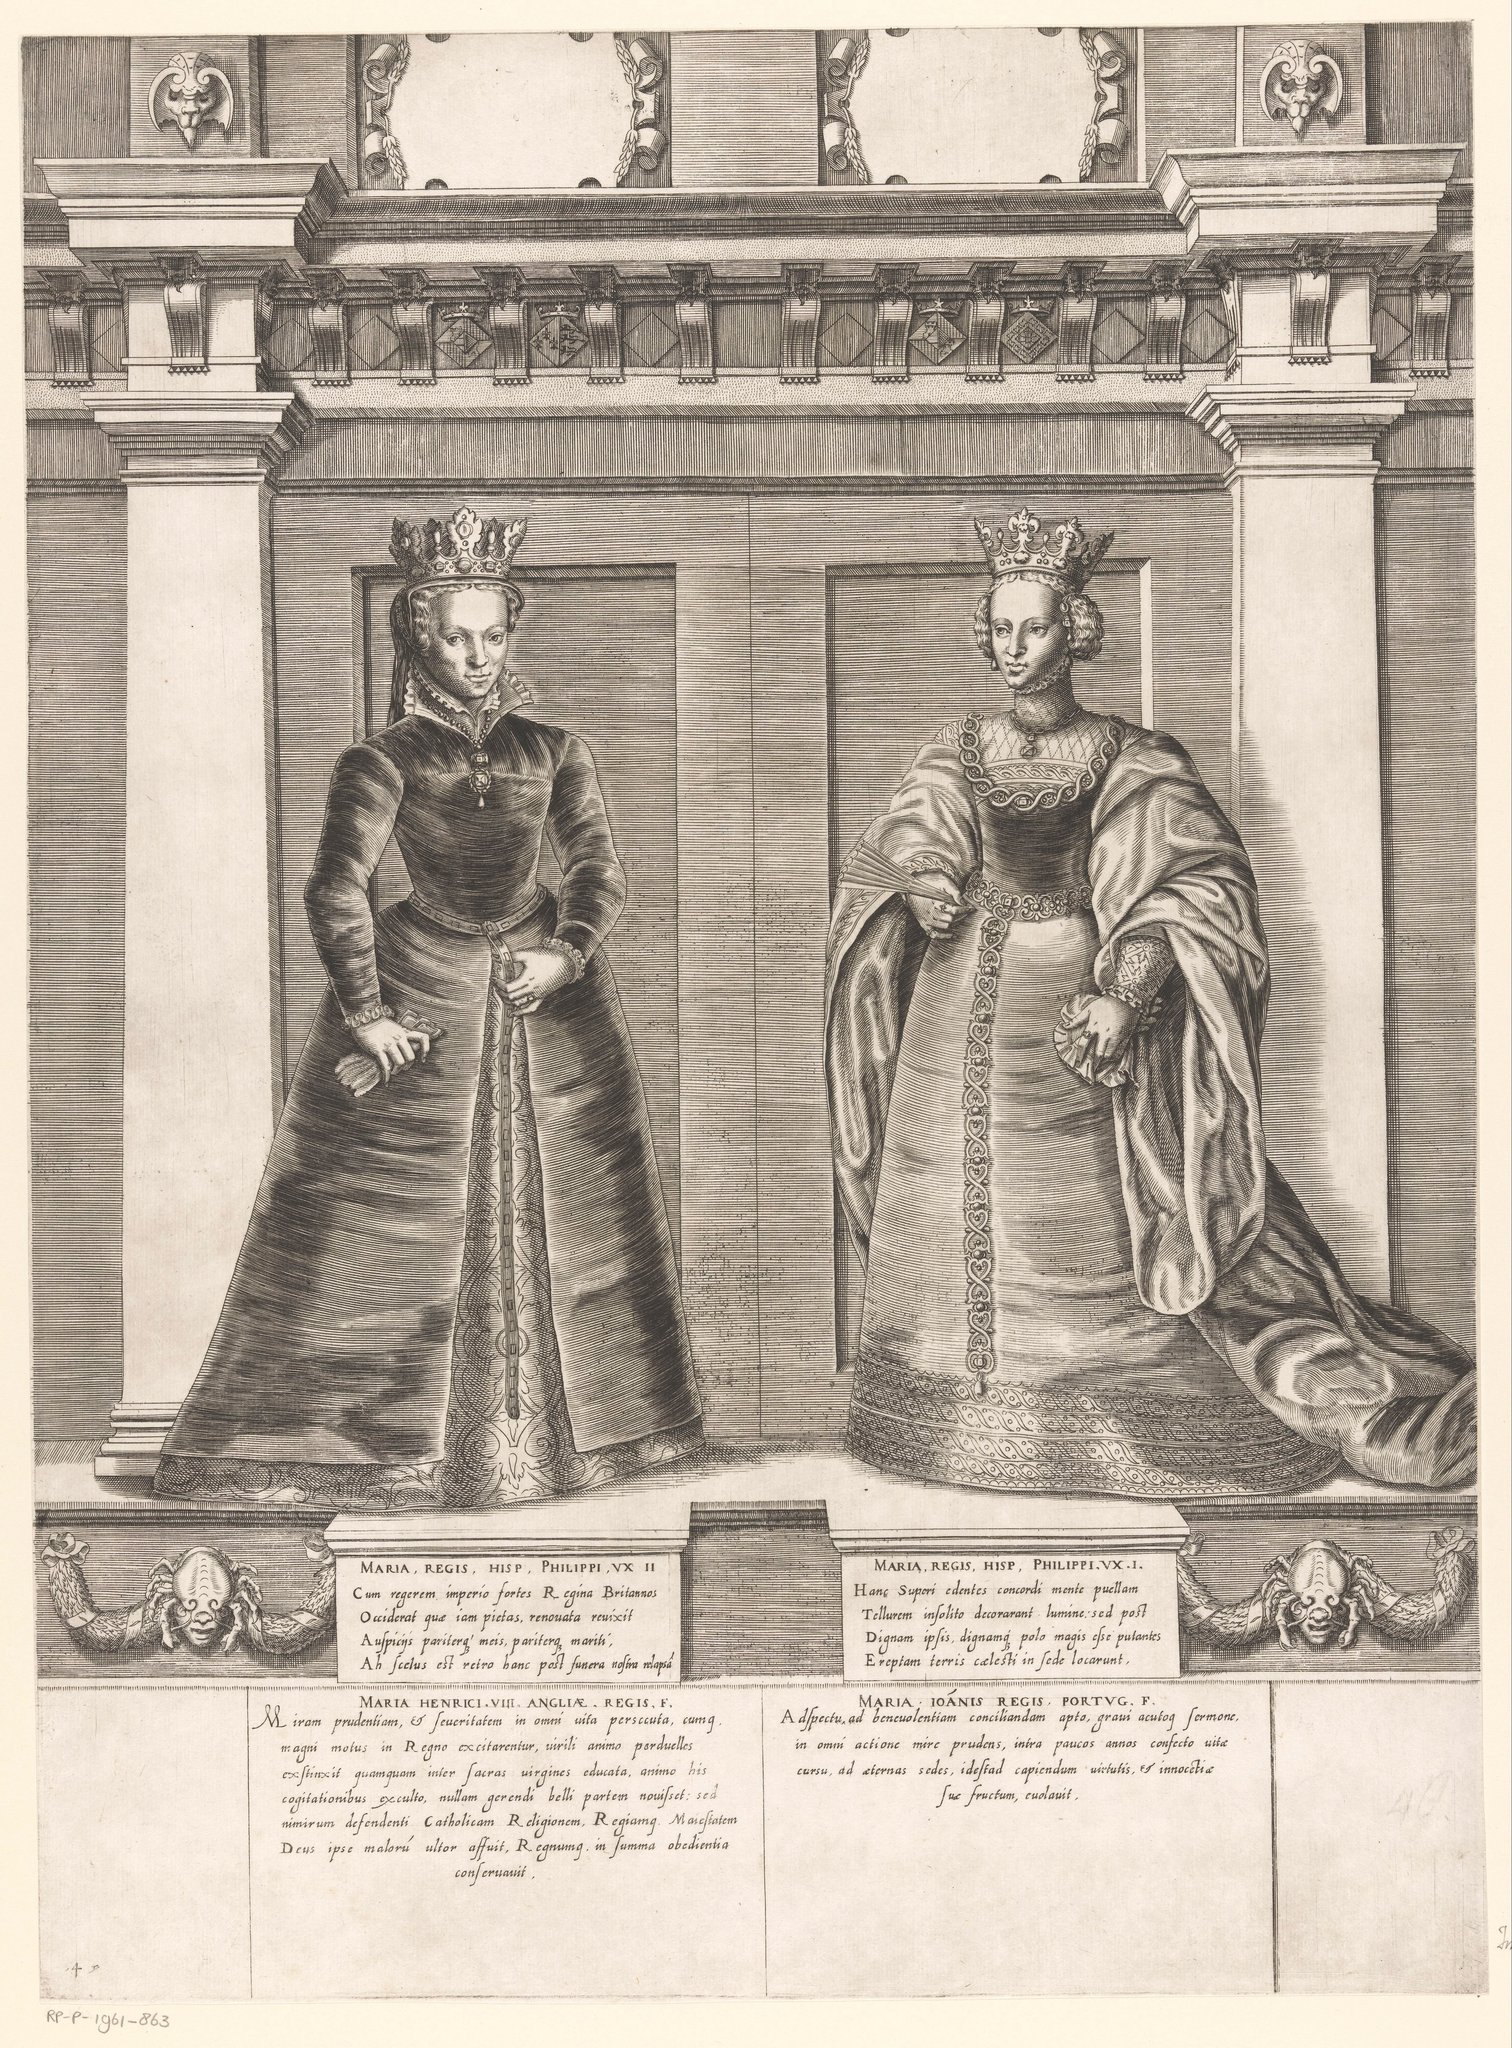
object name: print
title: Portret van Maria I van Engeland en Maria Emanuela van Portugal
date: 1569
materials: paper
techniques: engraving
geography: italy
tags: london, historical persons - bb - woman, ruler, sovereign - bb - female ruler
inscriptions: collector's mark: Lugt 2228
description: Deze prent maakt deel uit van een reeks van 58 prenten. Het meerendeel van de prenten bevat portretten van 74 leden van het Oostenrijkse Huis, naar tekeningen door Francesco Terzio, die deels getekend zijn naar de 28 levensgrote bronzen beelden die rond de cenotaaf van Maximiliaan I in de Hofkirche te Innsbruck staan. Op het object staat nummer 45, maar in de literatuur wordt de prent genoemd als prent 46 uit de reeks.